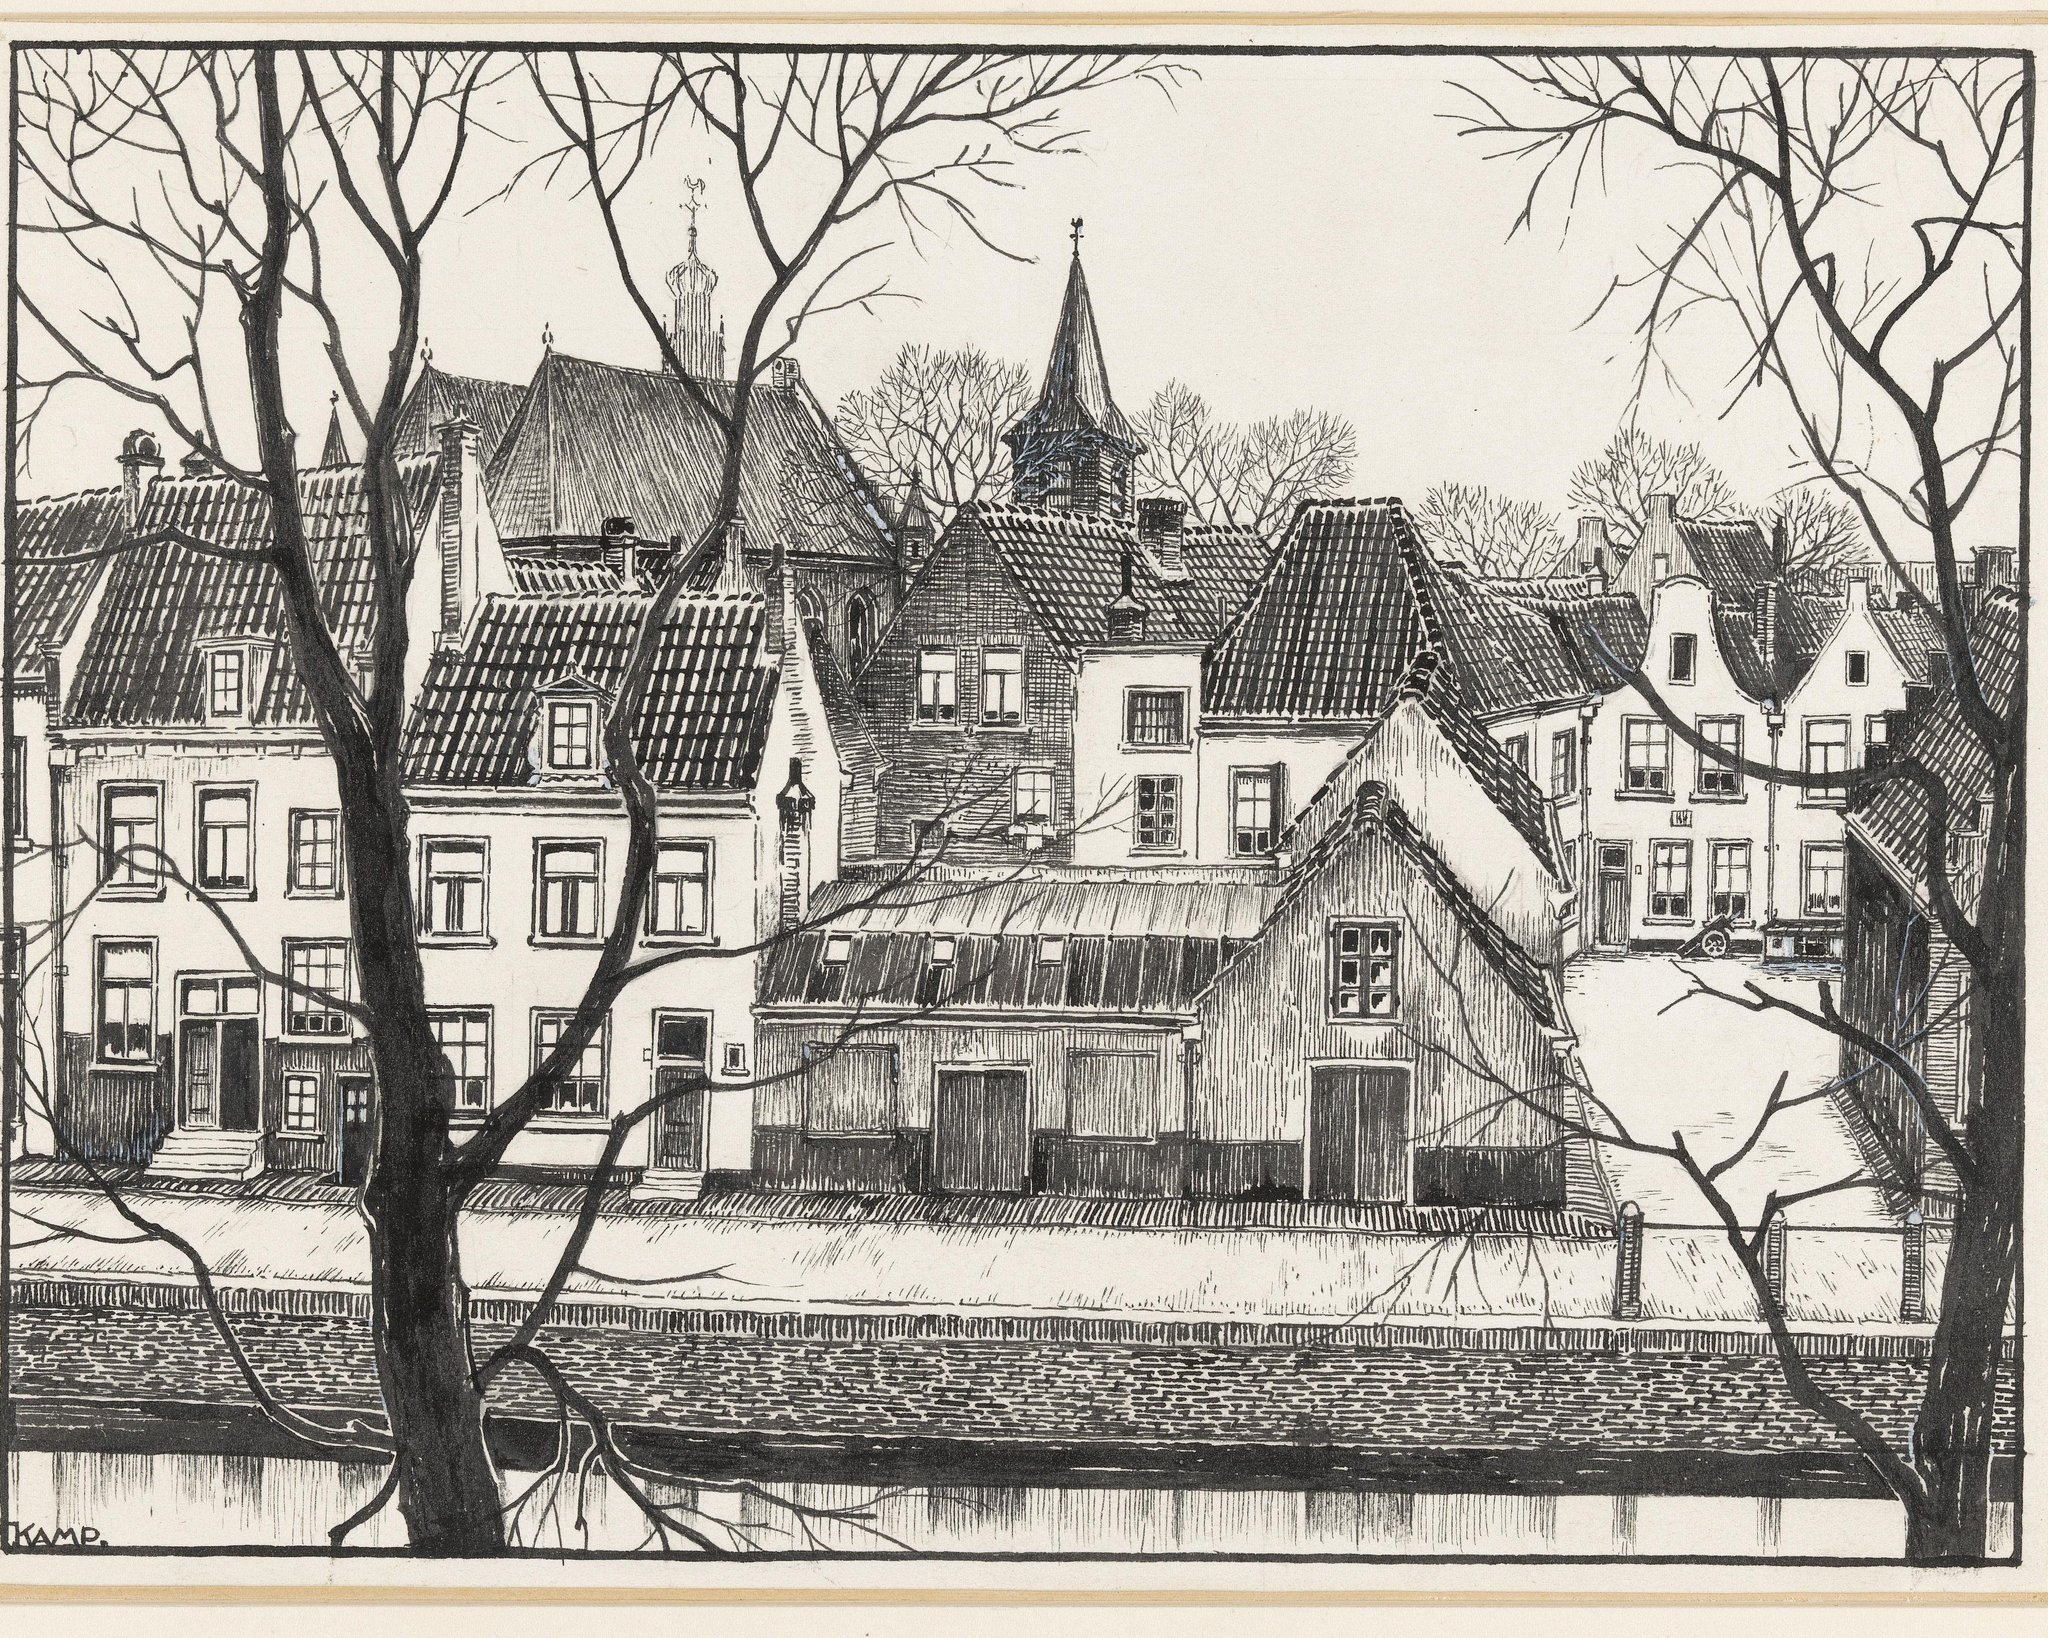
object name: drawing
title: Gezicht op de Bakenessergracht in Haarlem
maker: johan bernhard kamp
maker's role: draughtsman, print maker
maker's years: 1884-1953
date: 1894-1943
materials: paint, ink, paper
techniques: brush, pen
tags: canals, waters (in city), street, parts of church exterior and annexes: tower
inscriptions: collector's mark: Lugt 2228, inscription: ‘3’